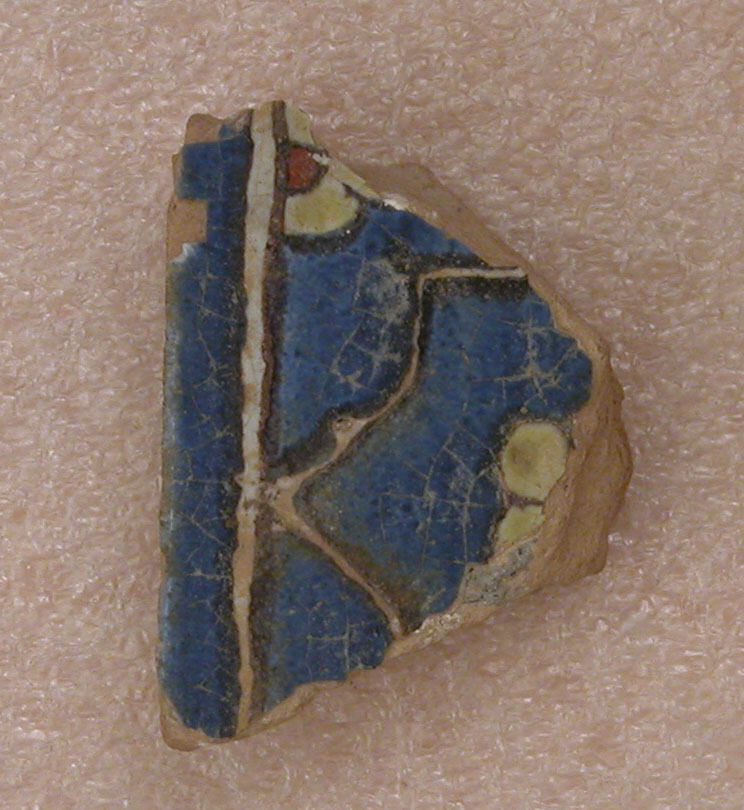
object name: tile fragment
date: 1334-1434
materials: glaze, stonepaste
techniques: painting, polychrome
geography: uzbekistan